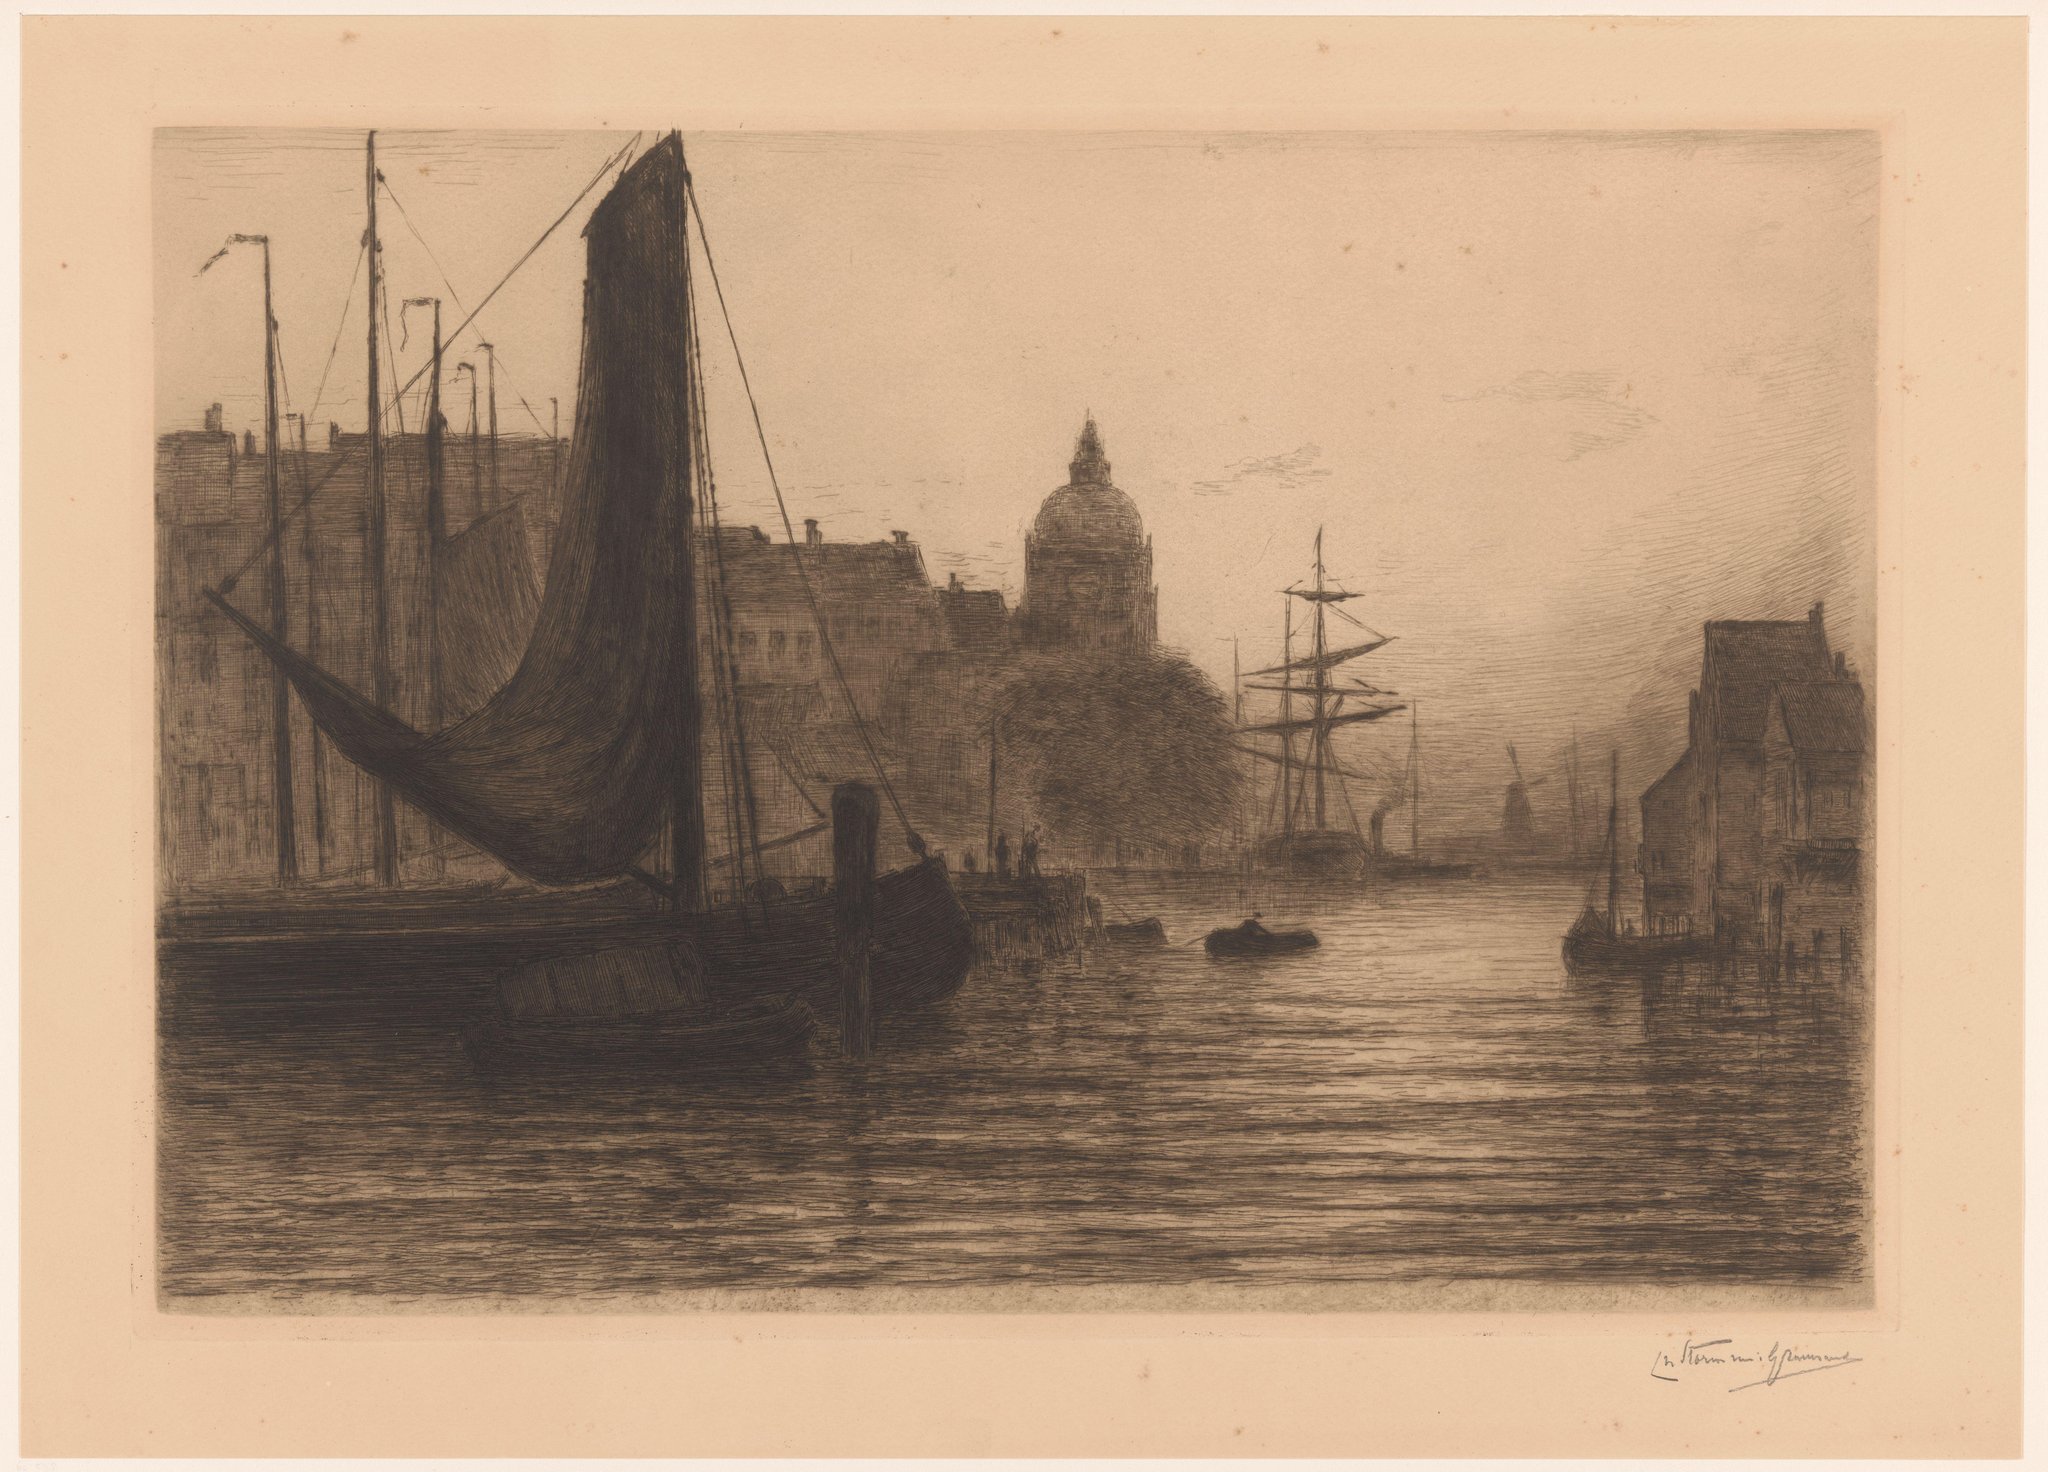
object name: print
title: Haven in Dordrecht bij avond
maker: carel nicolaas storm van s-gravesande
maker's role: draughtsman, print maker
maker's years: 1841-1924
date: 1887-1889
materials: paper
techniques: drypoint, etching, intaglio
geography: netherlands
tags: harbour, evening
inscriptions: number: ‘263’, collector's mark: Lugt 2228, inscription: ‘Haven Dordrecht’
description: Mogelijk ook vermeld in: Storm van 's-Gravesande, Charles. Catalogue des eaux-fortes et lithographies. New York: s.n., 1903, of in een onbekende latere uitgave van het manuscript. Vermoedelijk vermeld als catalogusnummer 263.